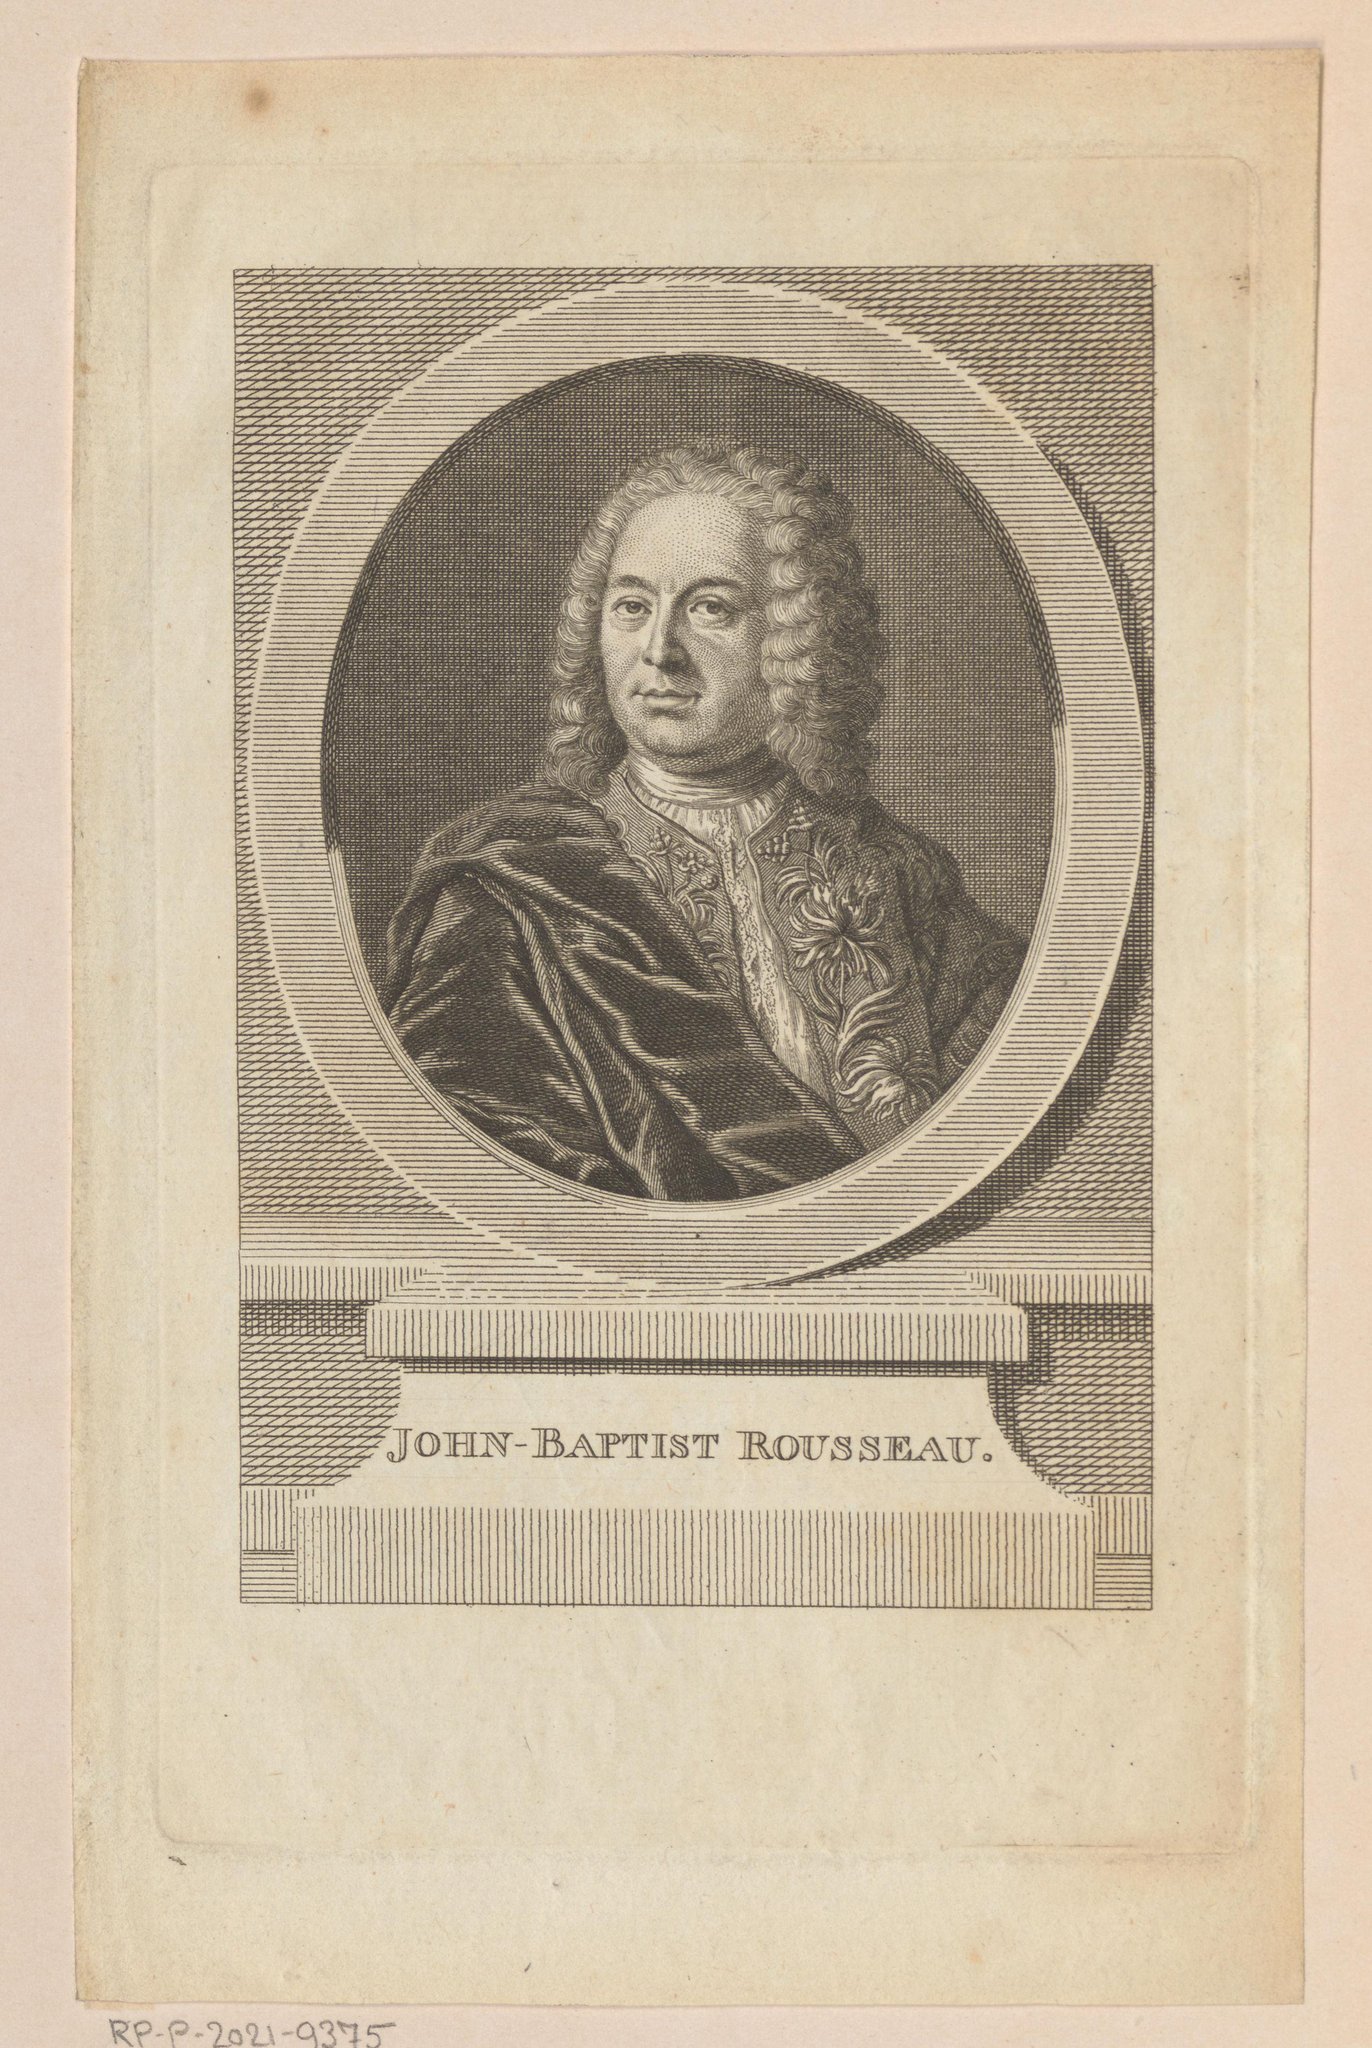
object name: print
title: Portret van Jean Baptiste Rousseau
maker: Anonymous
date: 1700-1749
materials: paper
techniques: engraving, etching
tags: paris, brussels, jean baptiste rousseau (1669-1741), historical persons